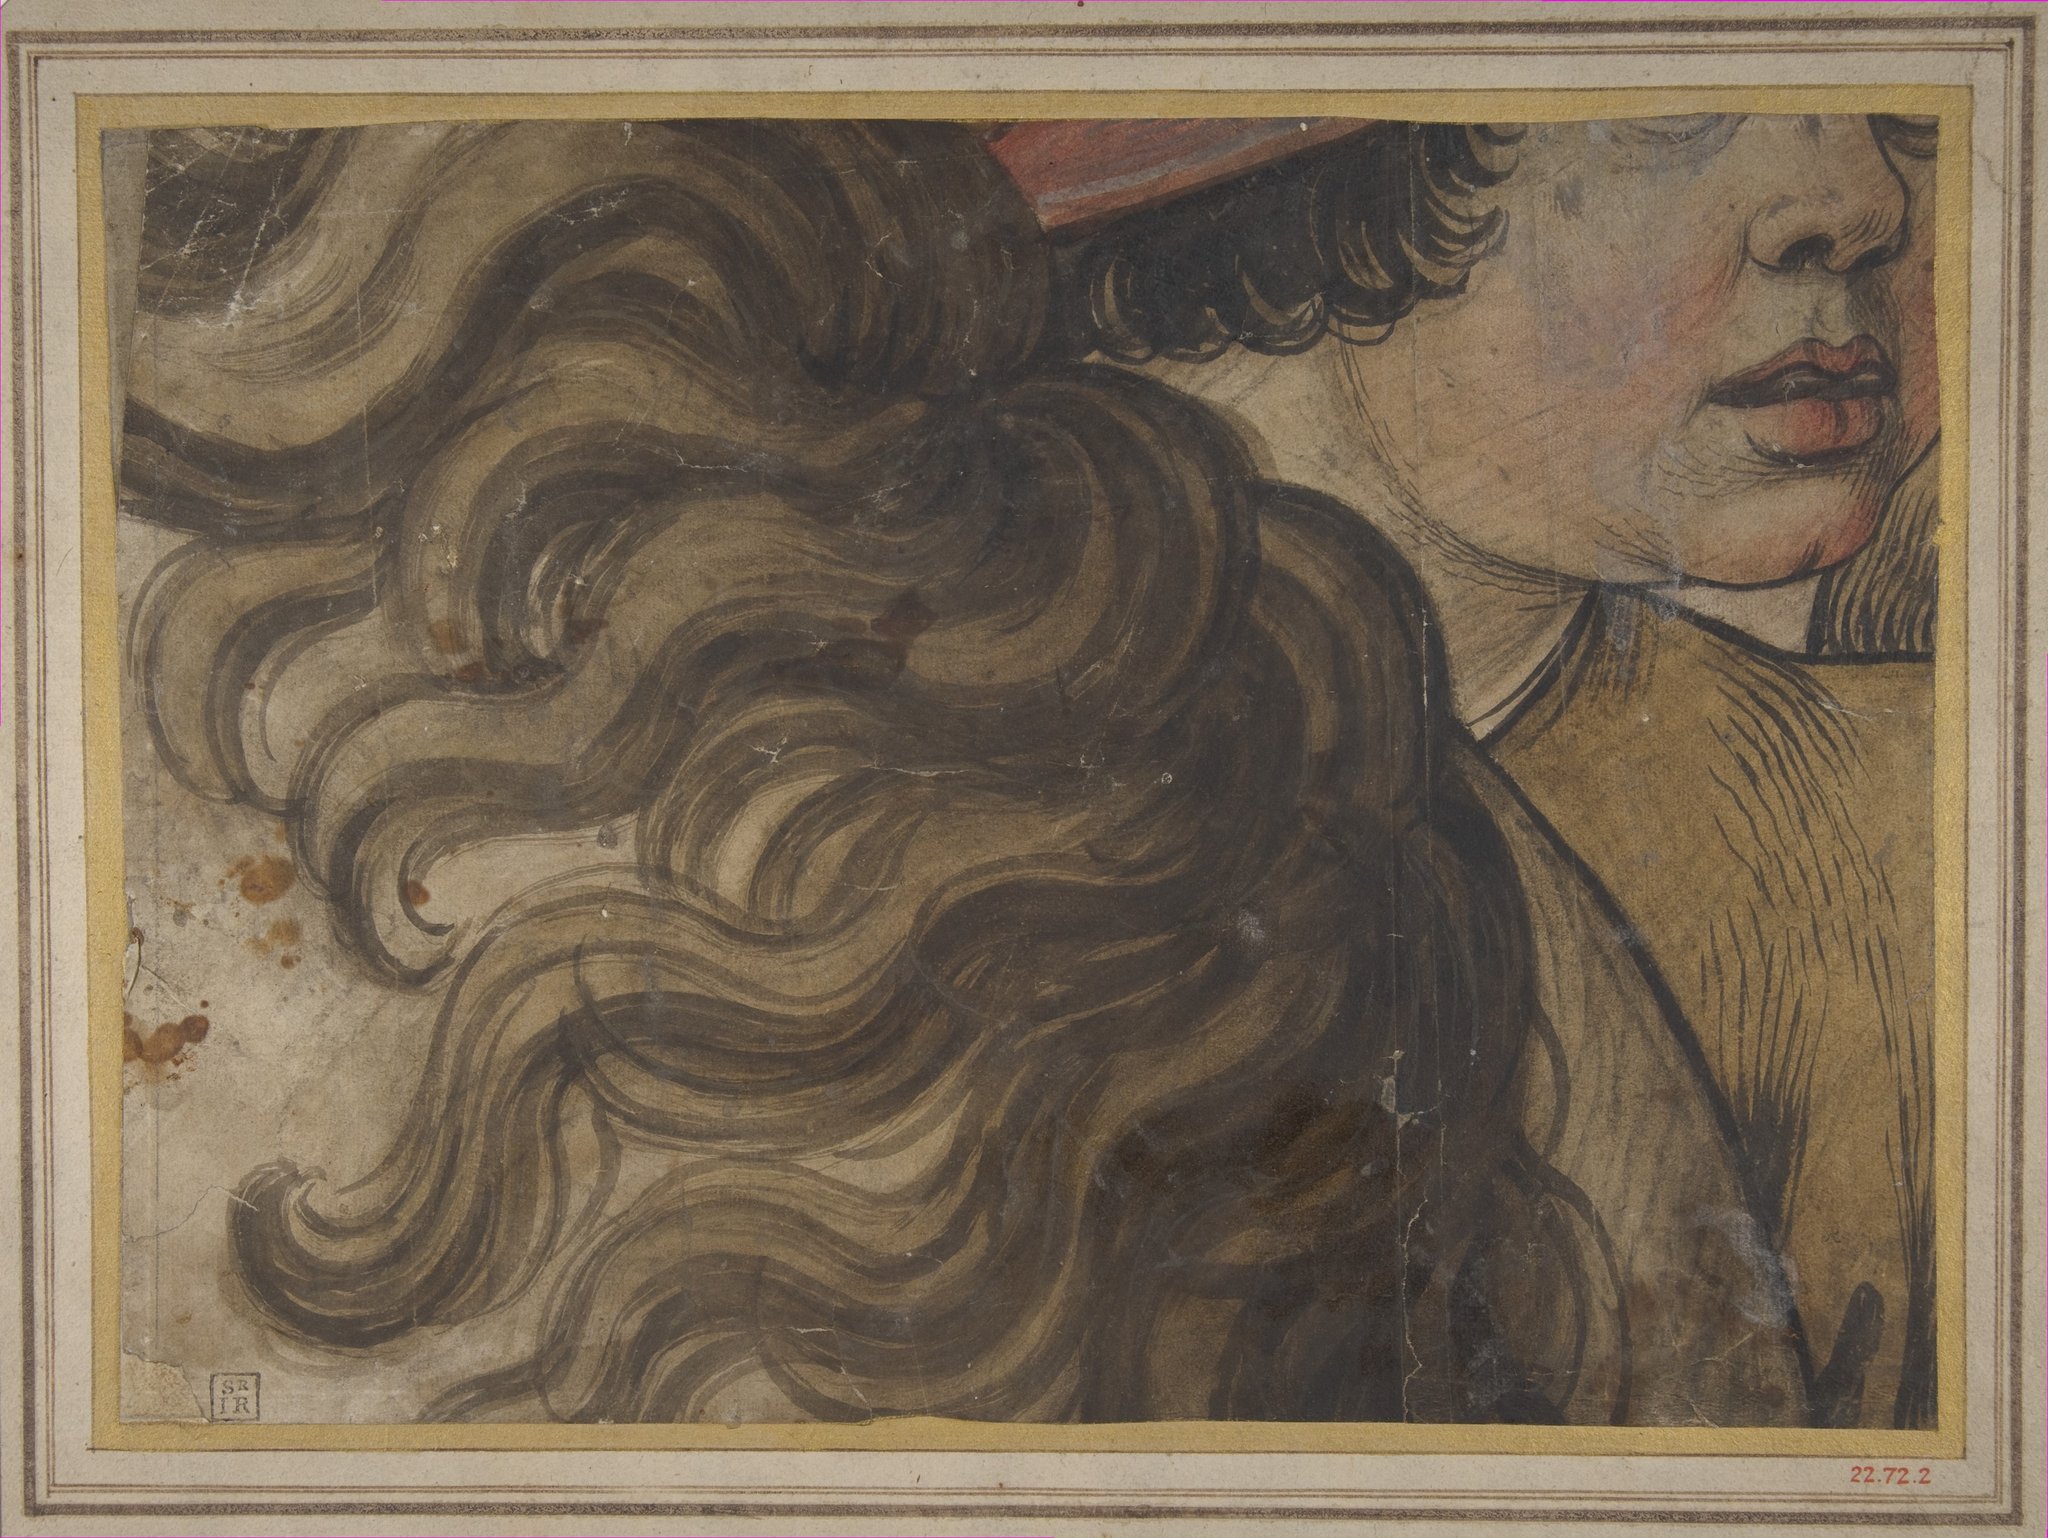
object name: drawing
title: Head of a boy and section of a horse's mane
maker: raphael (raffaello sanzio or santi)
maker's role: artist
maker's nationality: italian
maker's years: 1483-1520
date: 1500-1550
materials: chalk, gouache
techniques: brush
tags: heads,boys